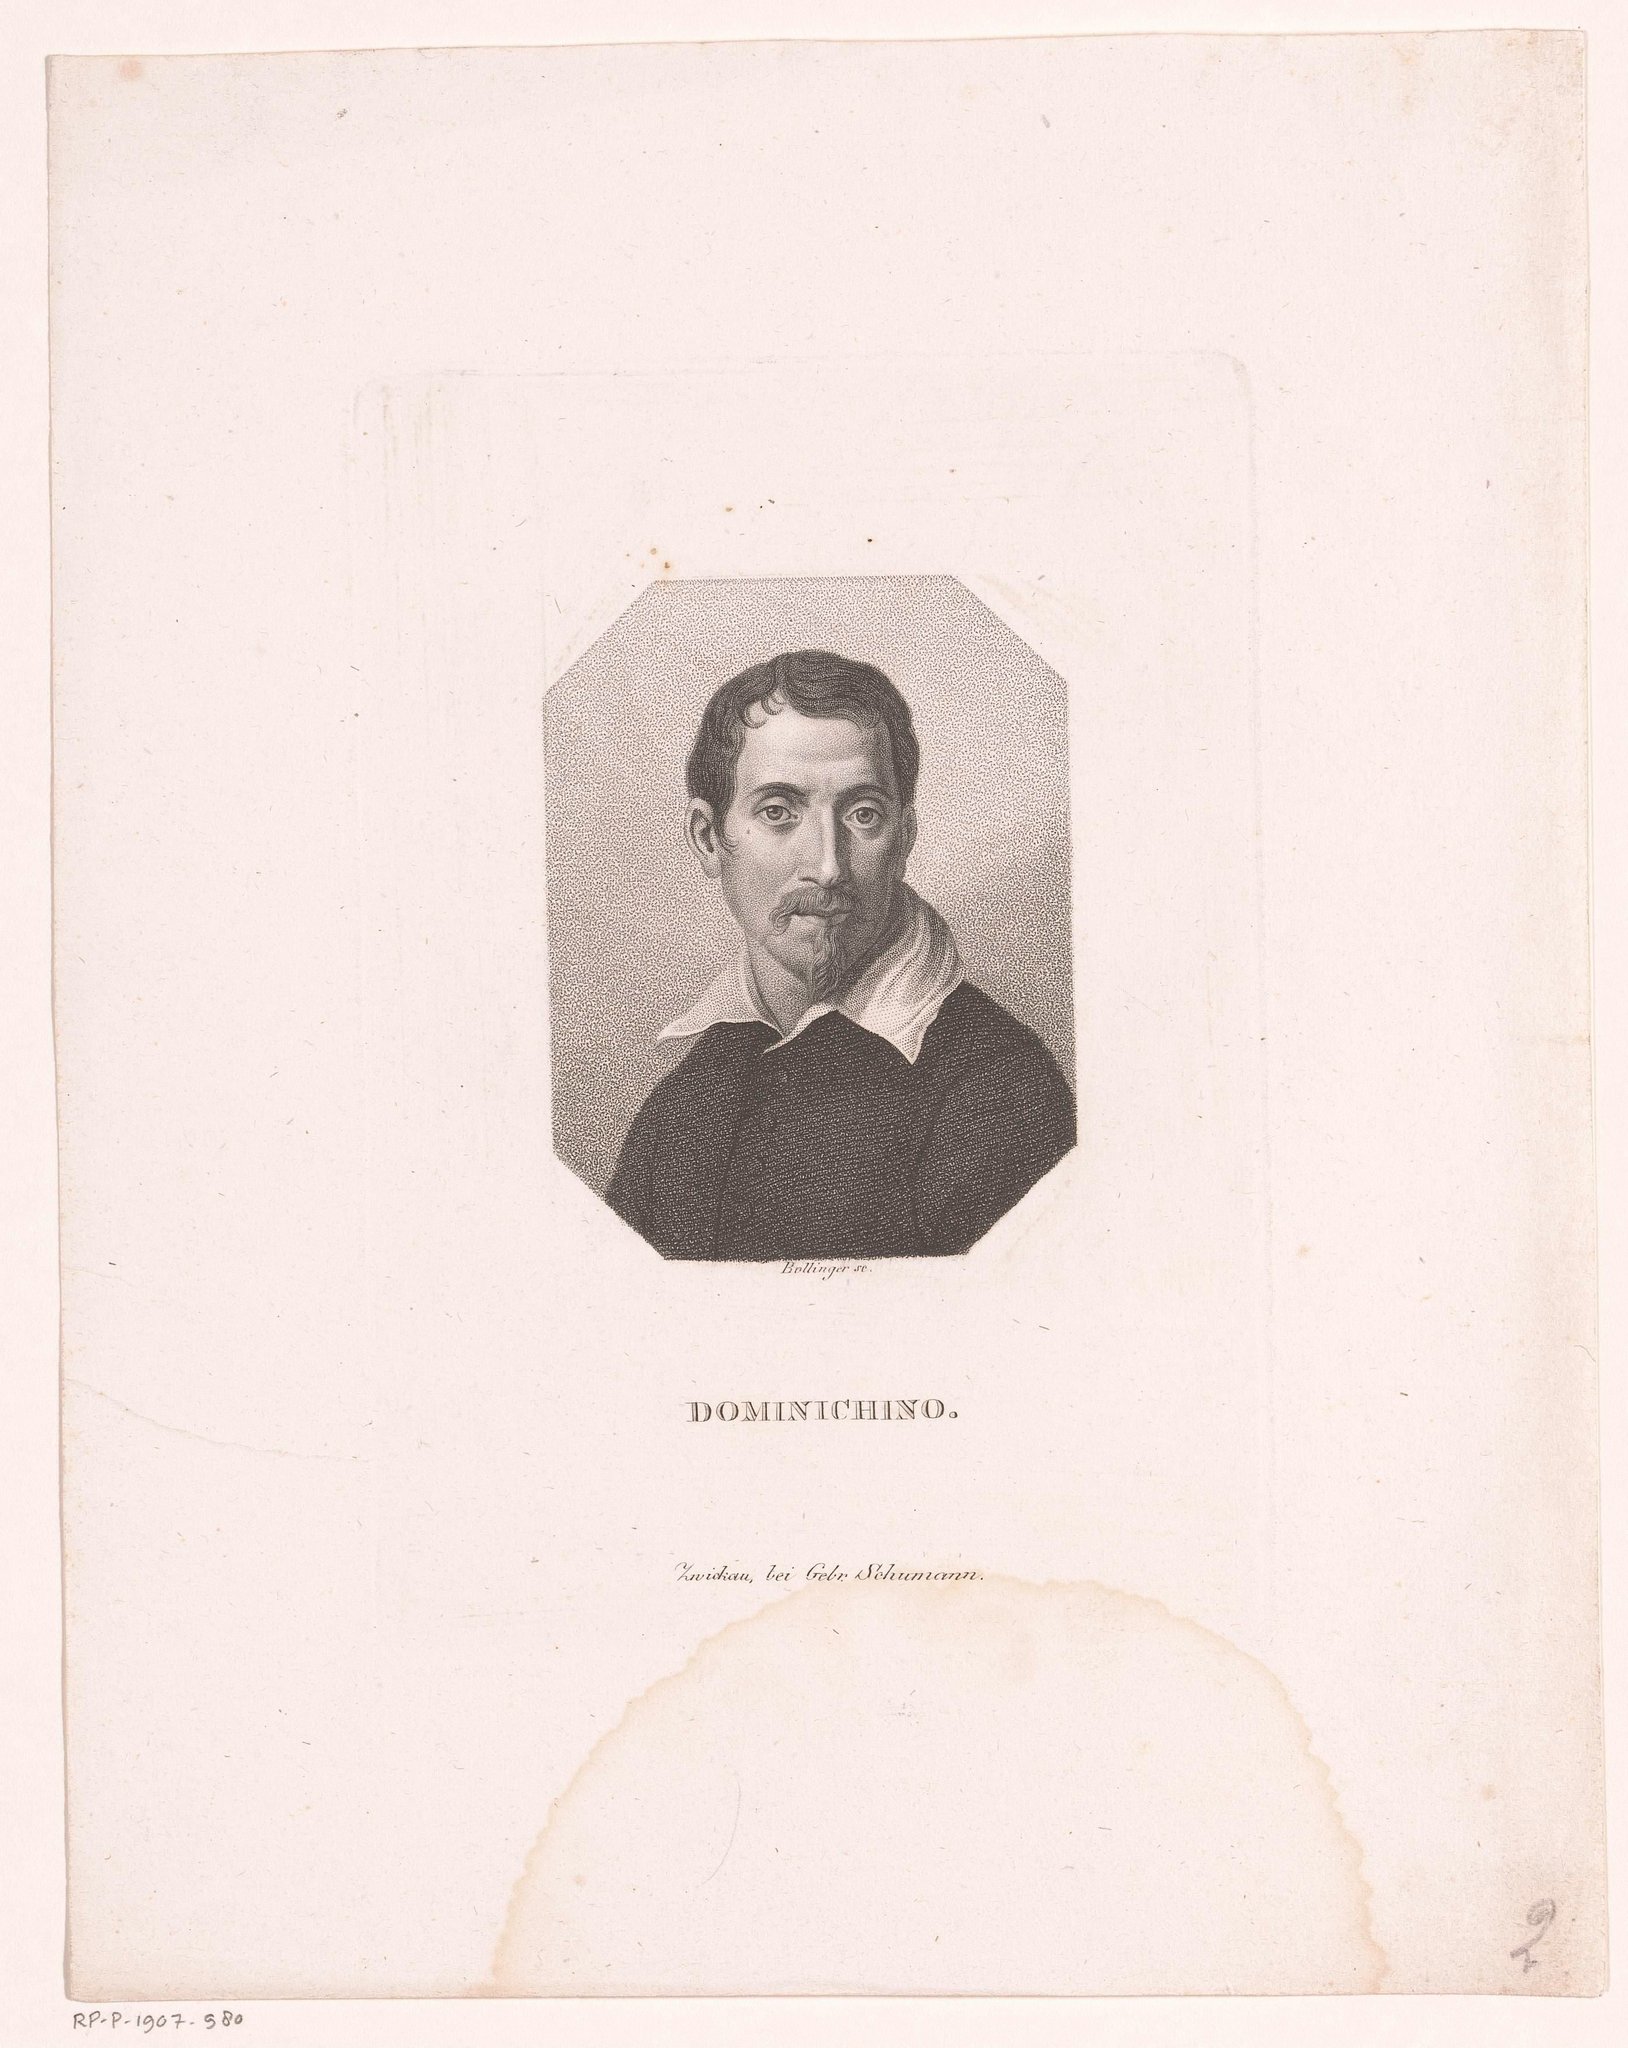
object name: print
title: Bildnisse der berühmtesten Menschen aller Völker und Zeiten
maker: friedrich wilhelm bollinger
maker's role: print maker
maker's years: 1777-1825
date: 1818-1832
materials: paper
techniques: stippling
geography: zwickau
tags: naples, draughtsman, domenichino, historical persons, portrait, self-portrait of painter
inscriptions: collector's mark: Lugt 2228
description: Prent gebruikt door de serie 'Bildnisse der berühmtesten Menschen aller Völker und Zeiten' van de gebroeders Schumann, uitgegeven in 1818-1832 te Zwickau.